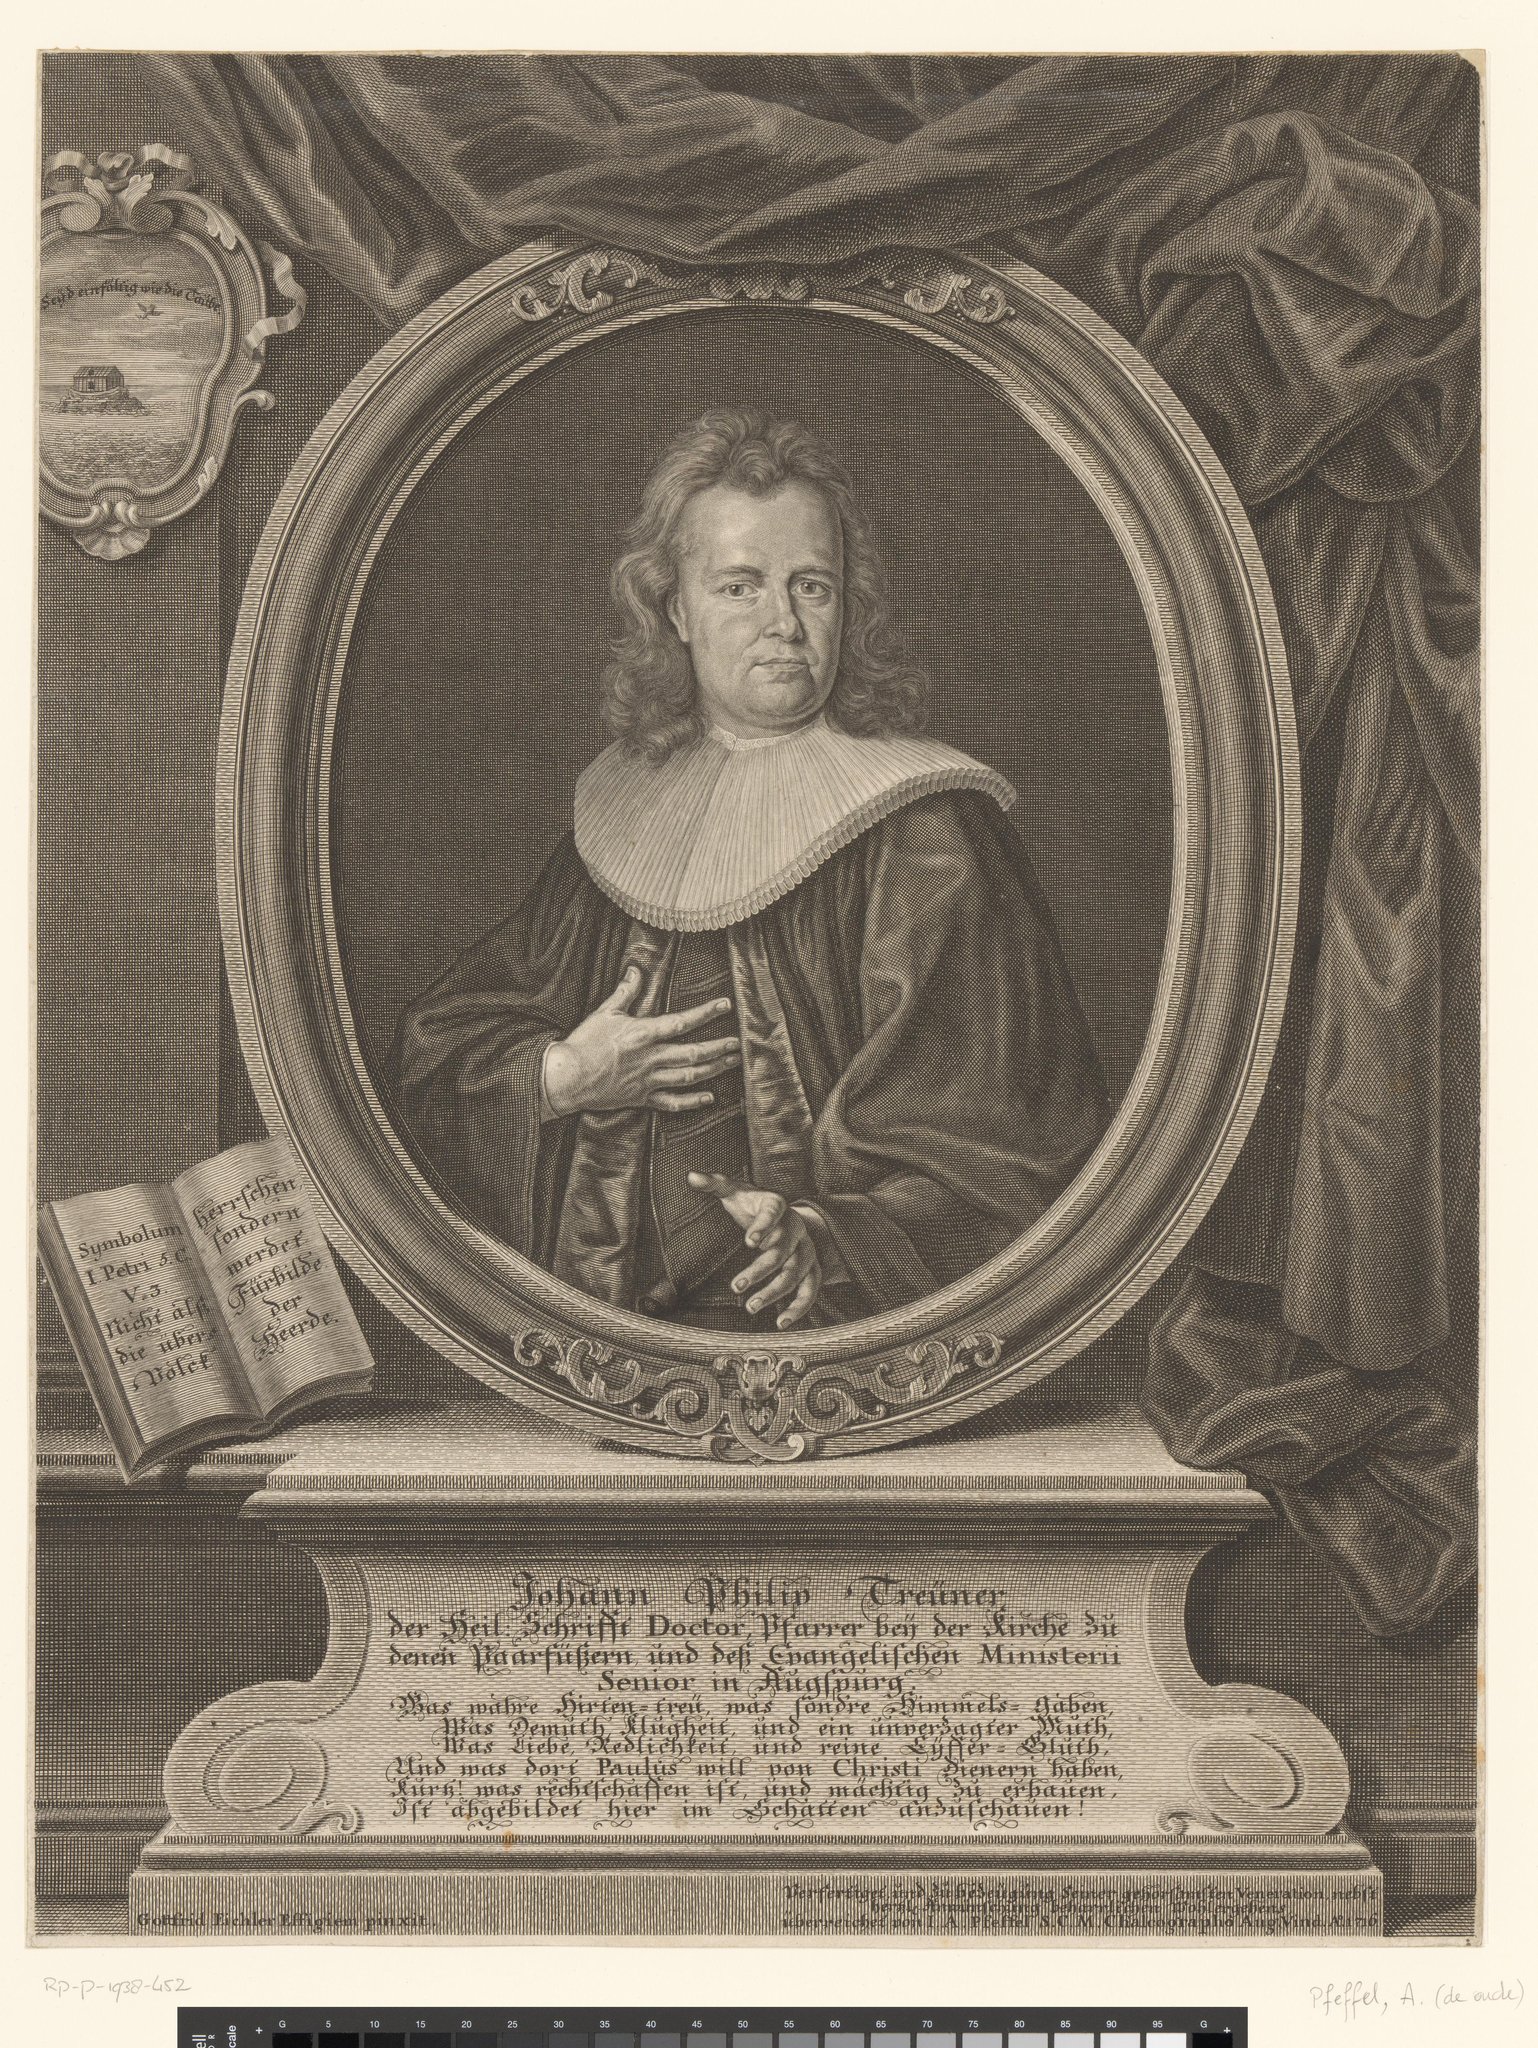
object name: print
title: Portret van Johann Philipp Treuner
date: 1716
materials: paper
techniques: engraving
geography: augsburg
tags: historical persons, book, armorial bearing, heraldry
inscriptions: collector's mark: Lugt 2228